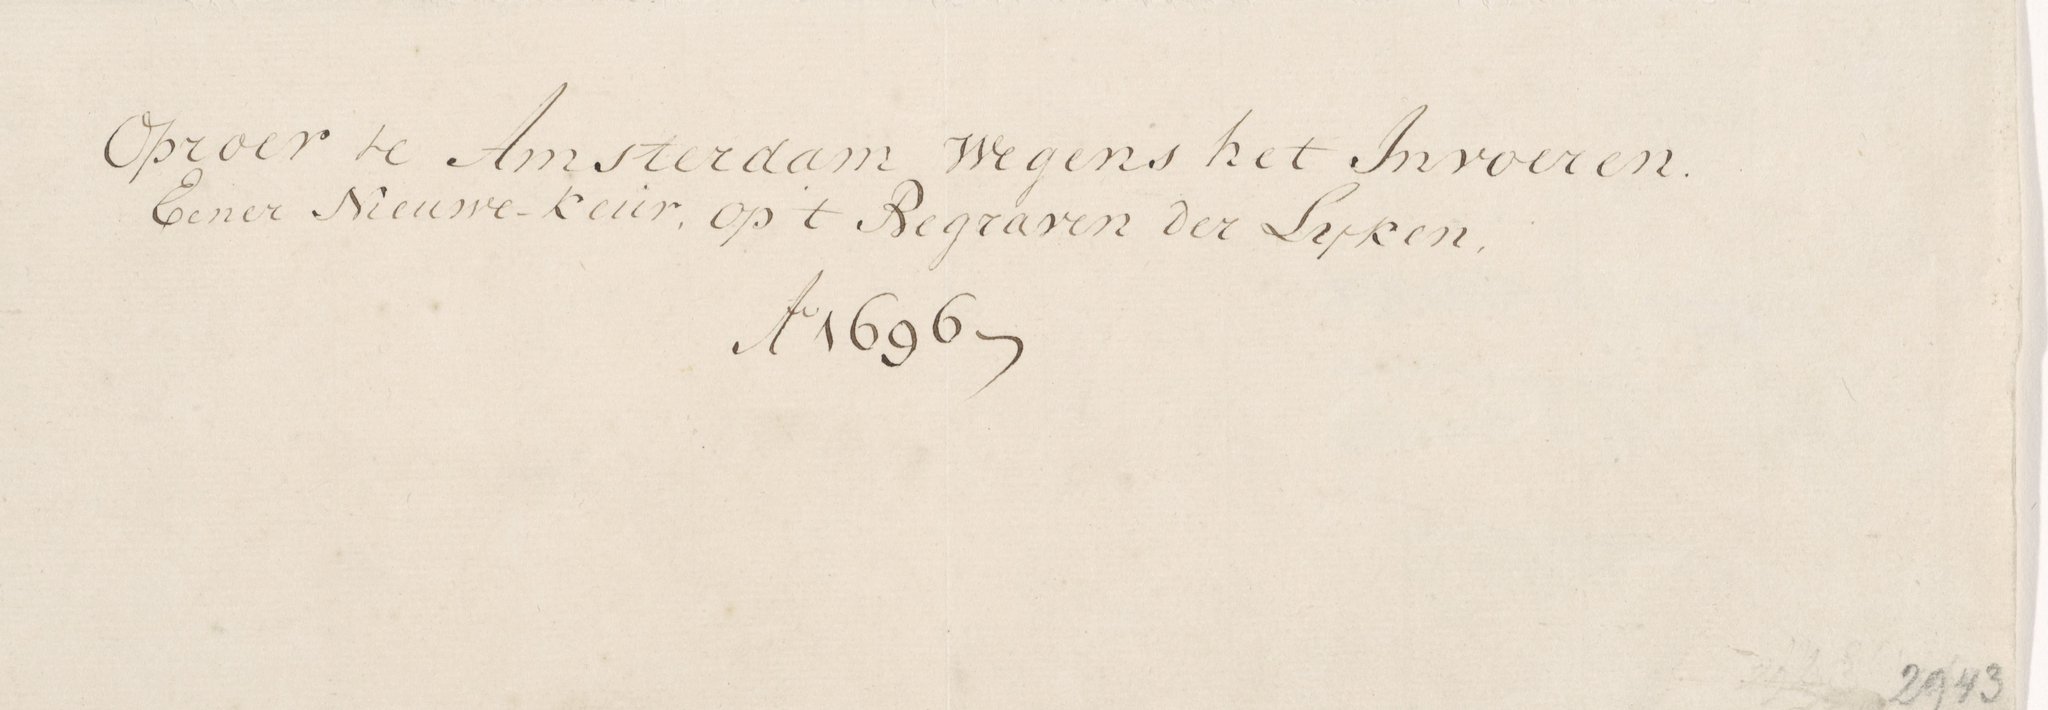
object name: text sheet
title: Oproer te Amsterdam wegens het invoeren eener nieuwe-keur op 't begraven der lyken, An. 1696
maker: Anonymous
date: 1696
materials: ink, paper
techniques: pen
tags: amsterdam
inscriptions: collector's mark: Lugt 2228